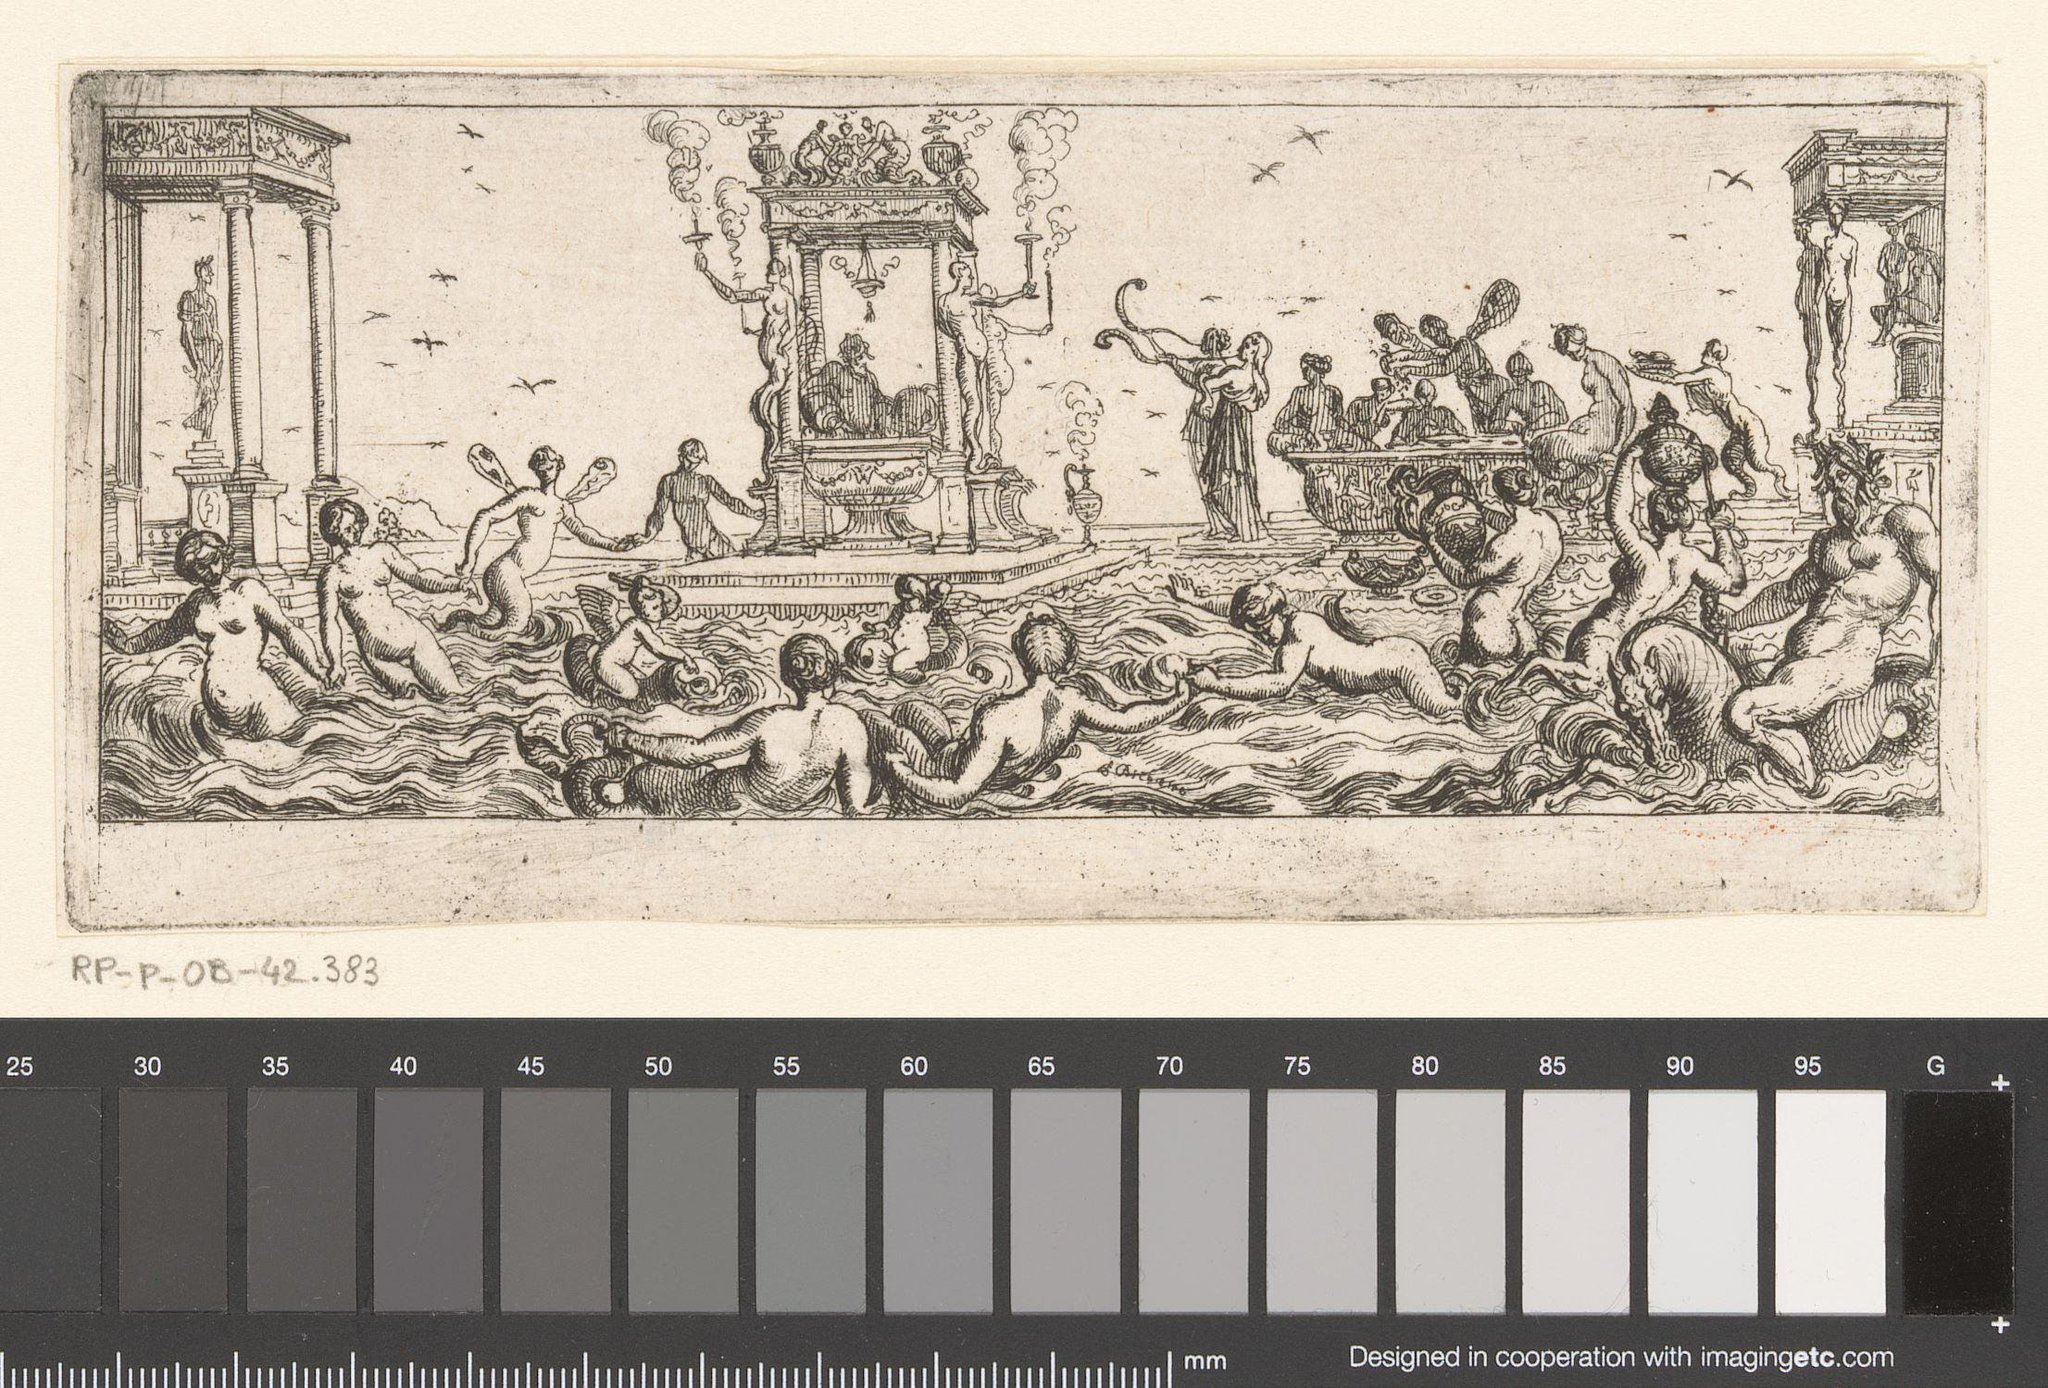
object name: print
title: Getroonde Neptunus met nereïden en tritons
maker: pierre brebiette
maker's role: draughtsman, print maker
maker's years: 1598-1650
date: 1608-1650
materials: paper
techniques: etching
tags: (story of) neptune (poseidon), triton(s), nereids, daughters of nereus; sea-nymphs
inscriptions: collector's mark: Lugt 240